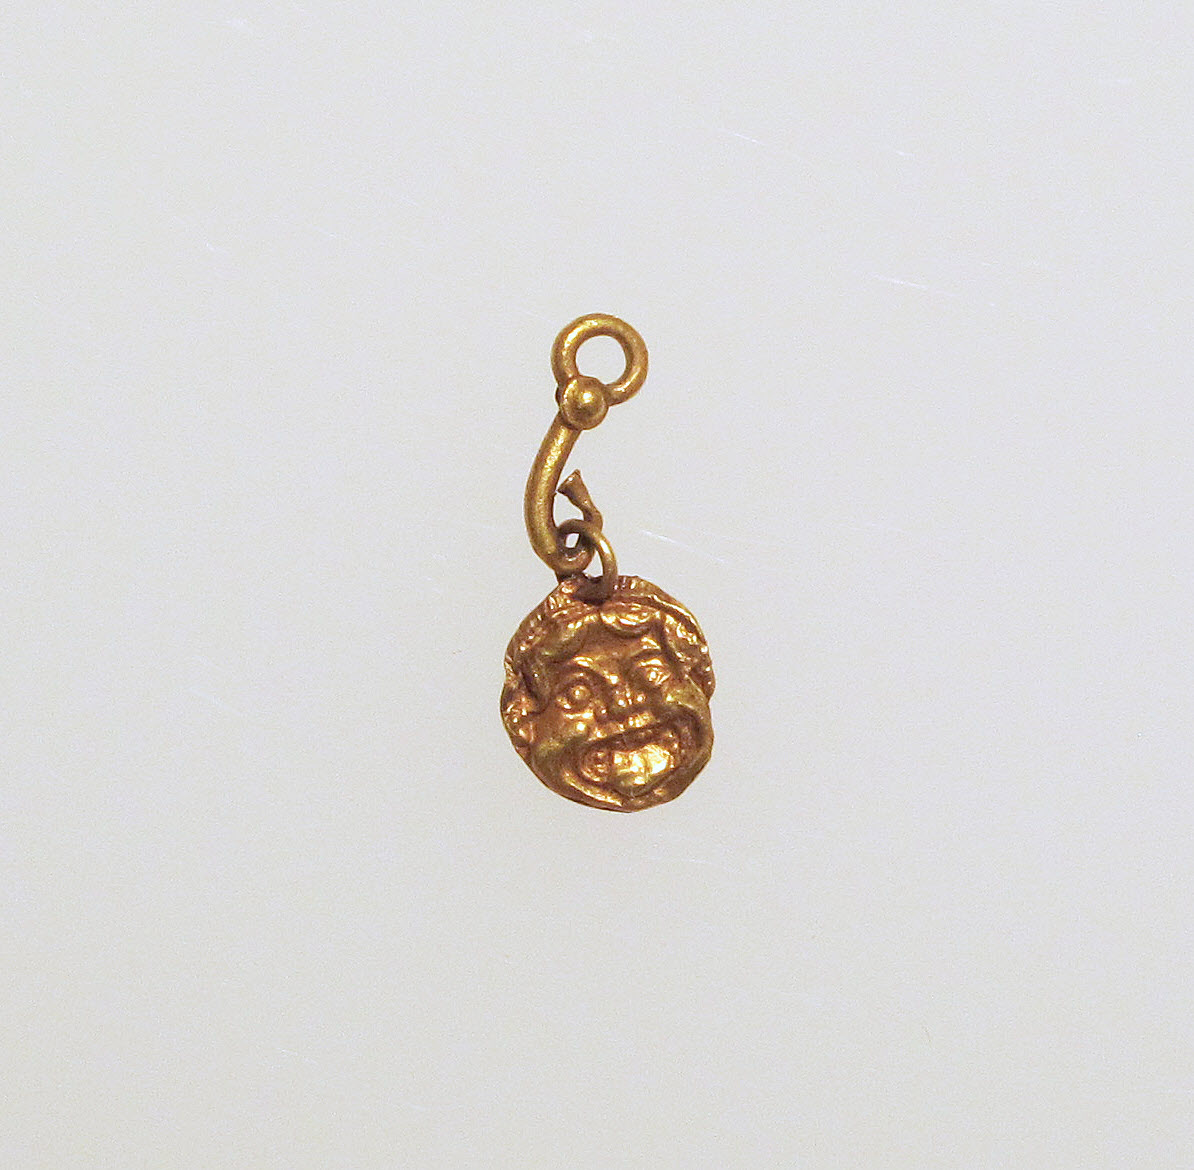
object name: pendant in the form of a gorgoneion eye charm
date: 7000 BCE-330 CE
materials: gold